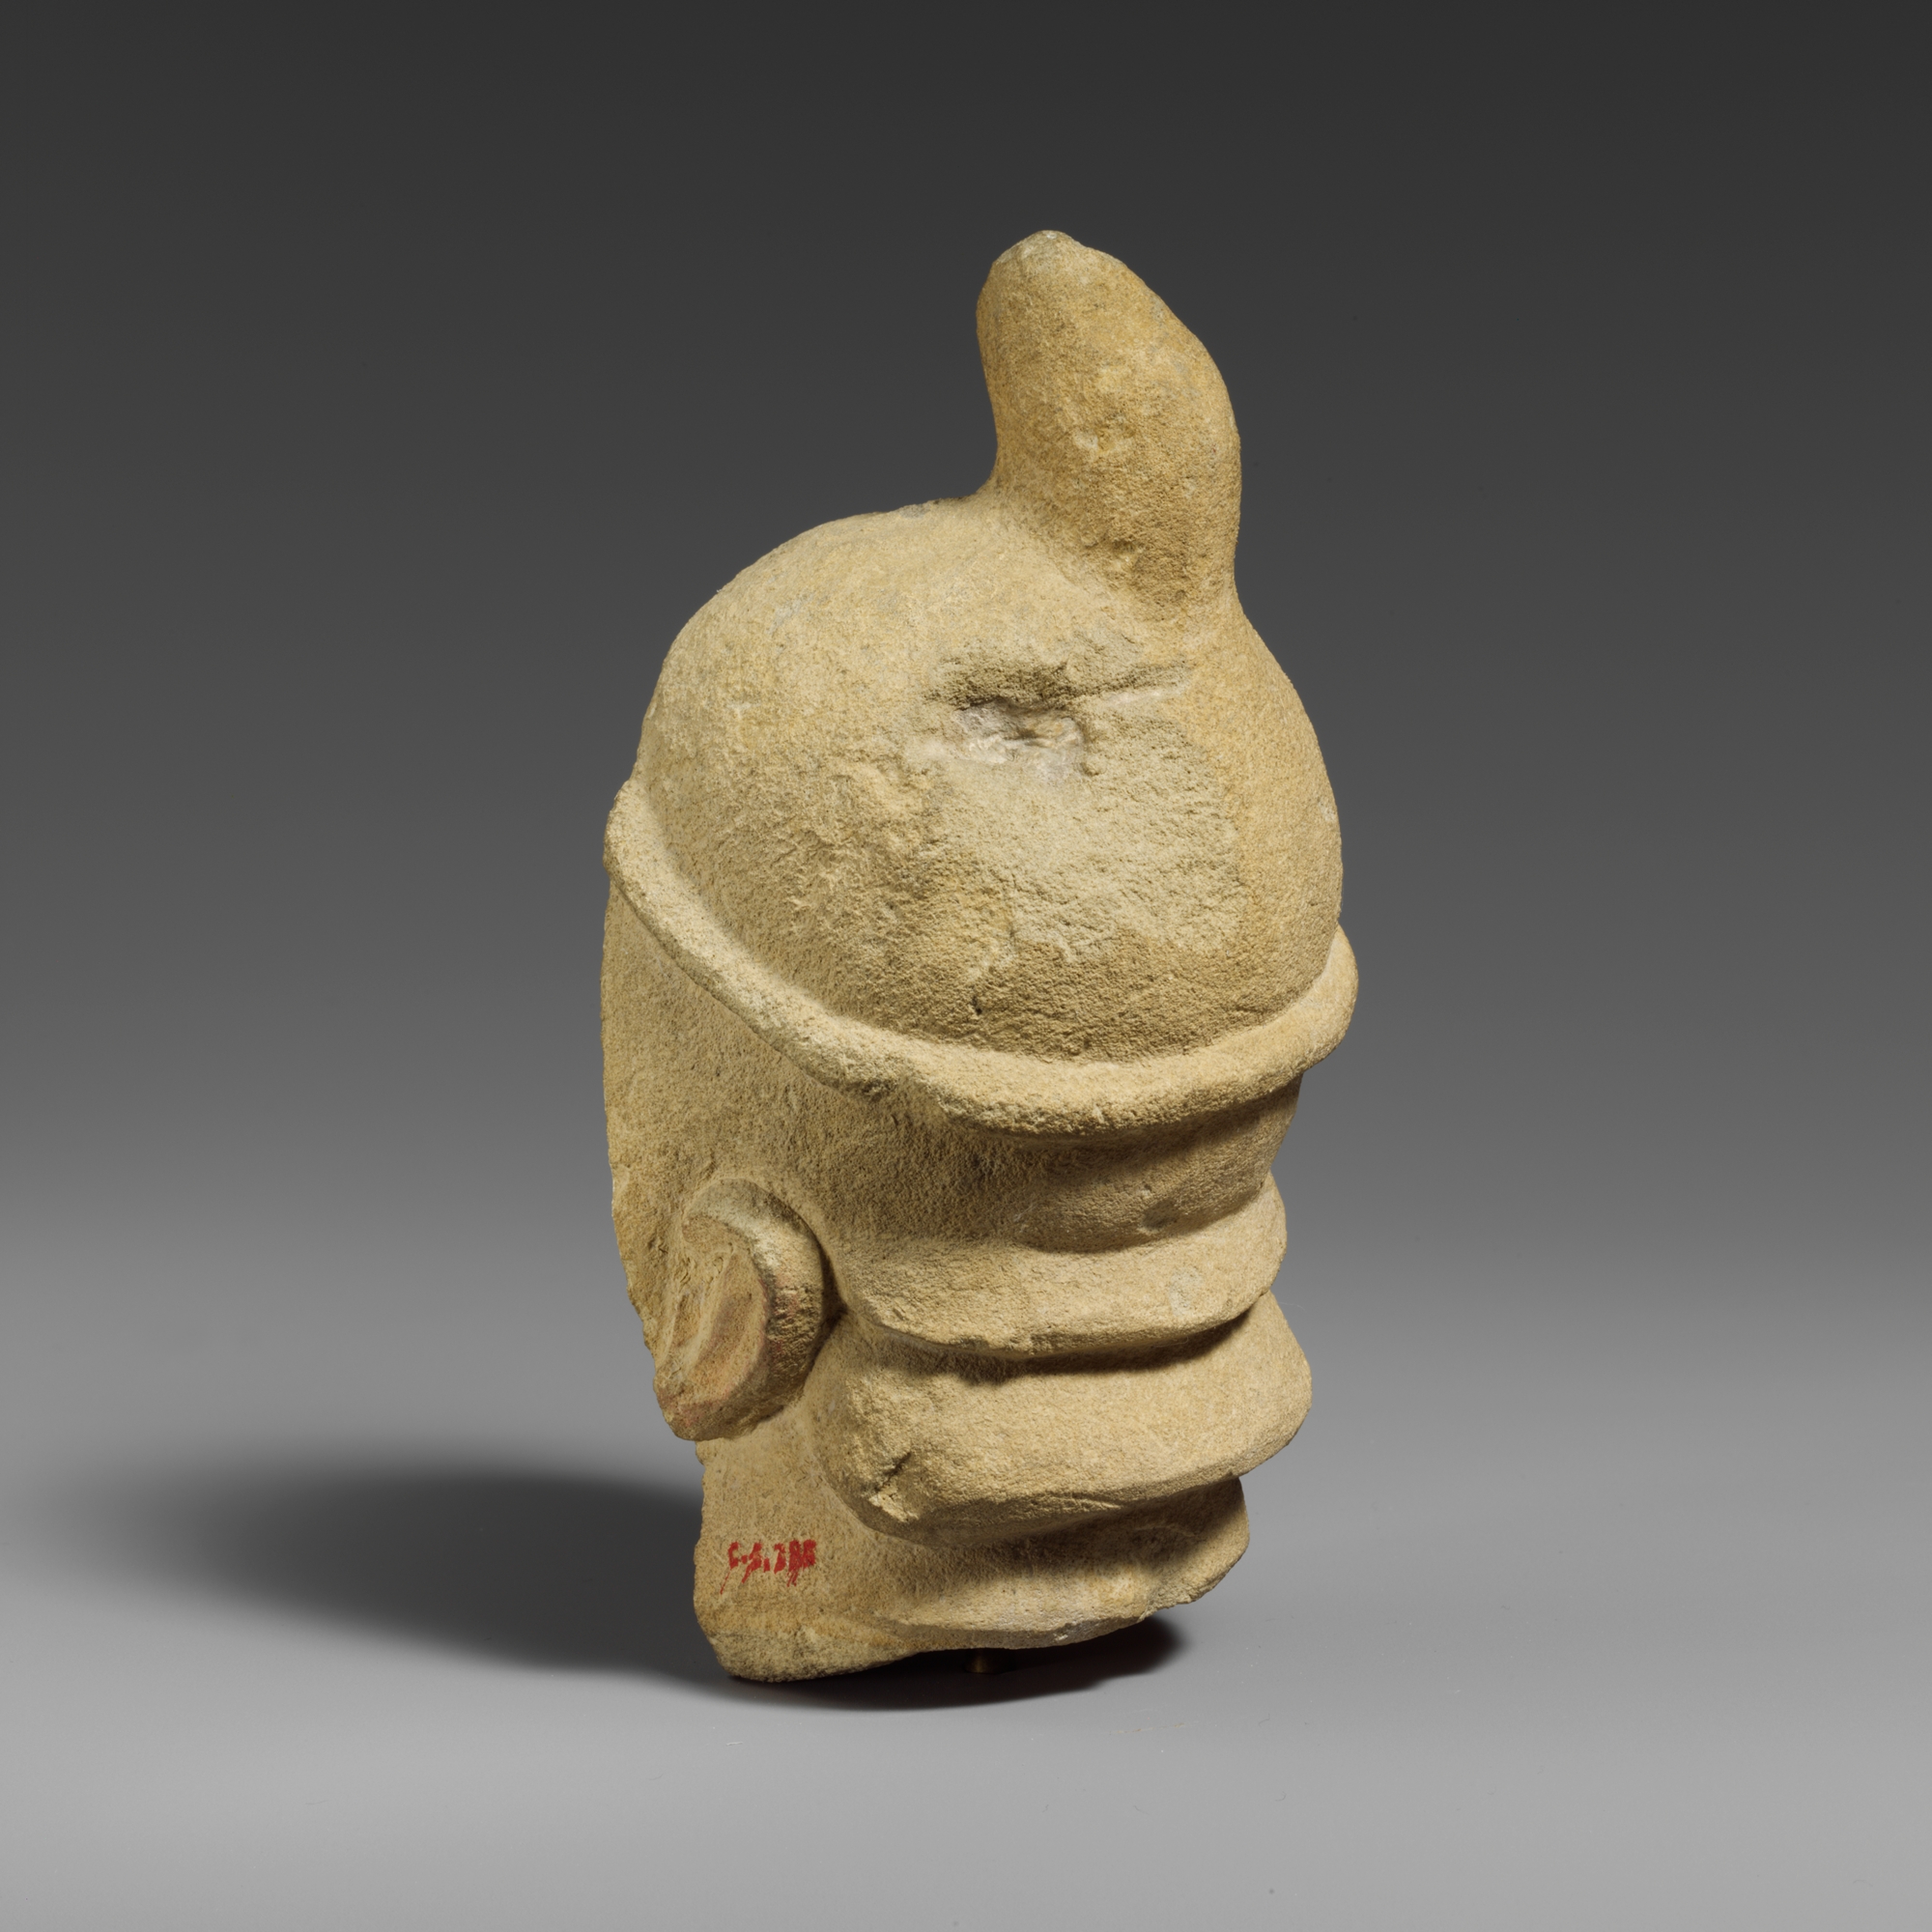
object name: head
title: Fragment of a limestone head of the “Triple Geryon” (?)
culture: cypriot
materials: limestone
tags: helmets,heads